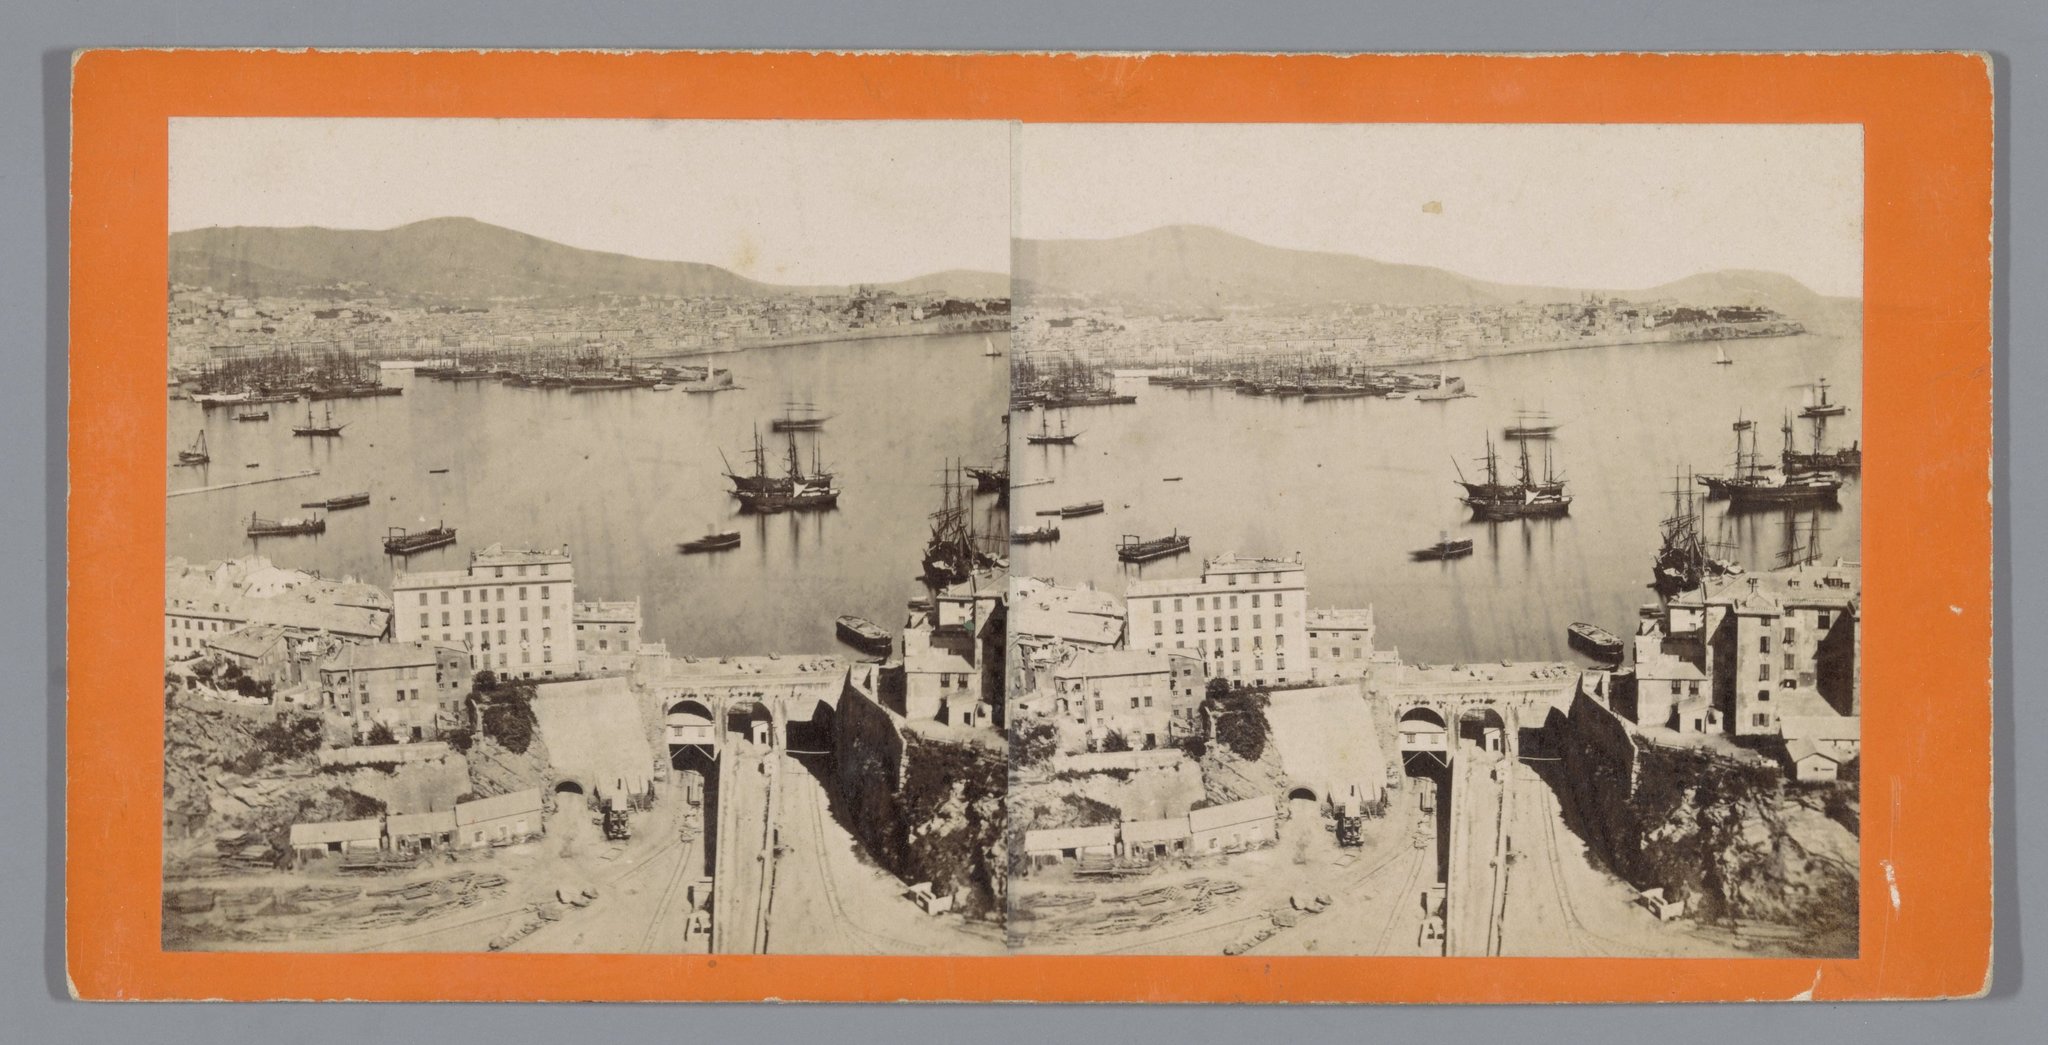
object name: stereograph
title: Gezicht op de haven van Genua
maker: Anonymous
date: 1850-1880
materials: cardboard, photographic support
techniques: albumen print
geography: genoa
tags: harbour, city-view in general; 'veduta'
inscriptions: inscription: ‘Genova - Panorama dalla Cada’